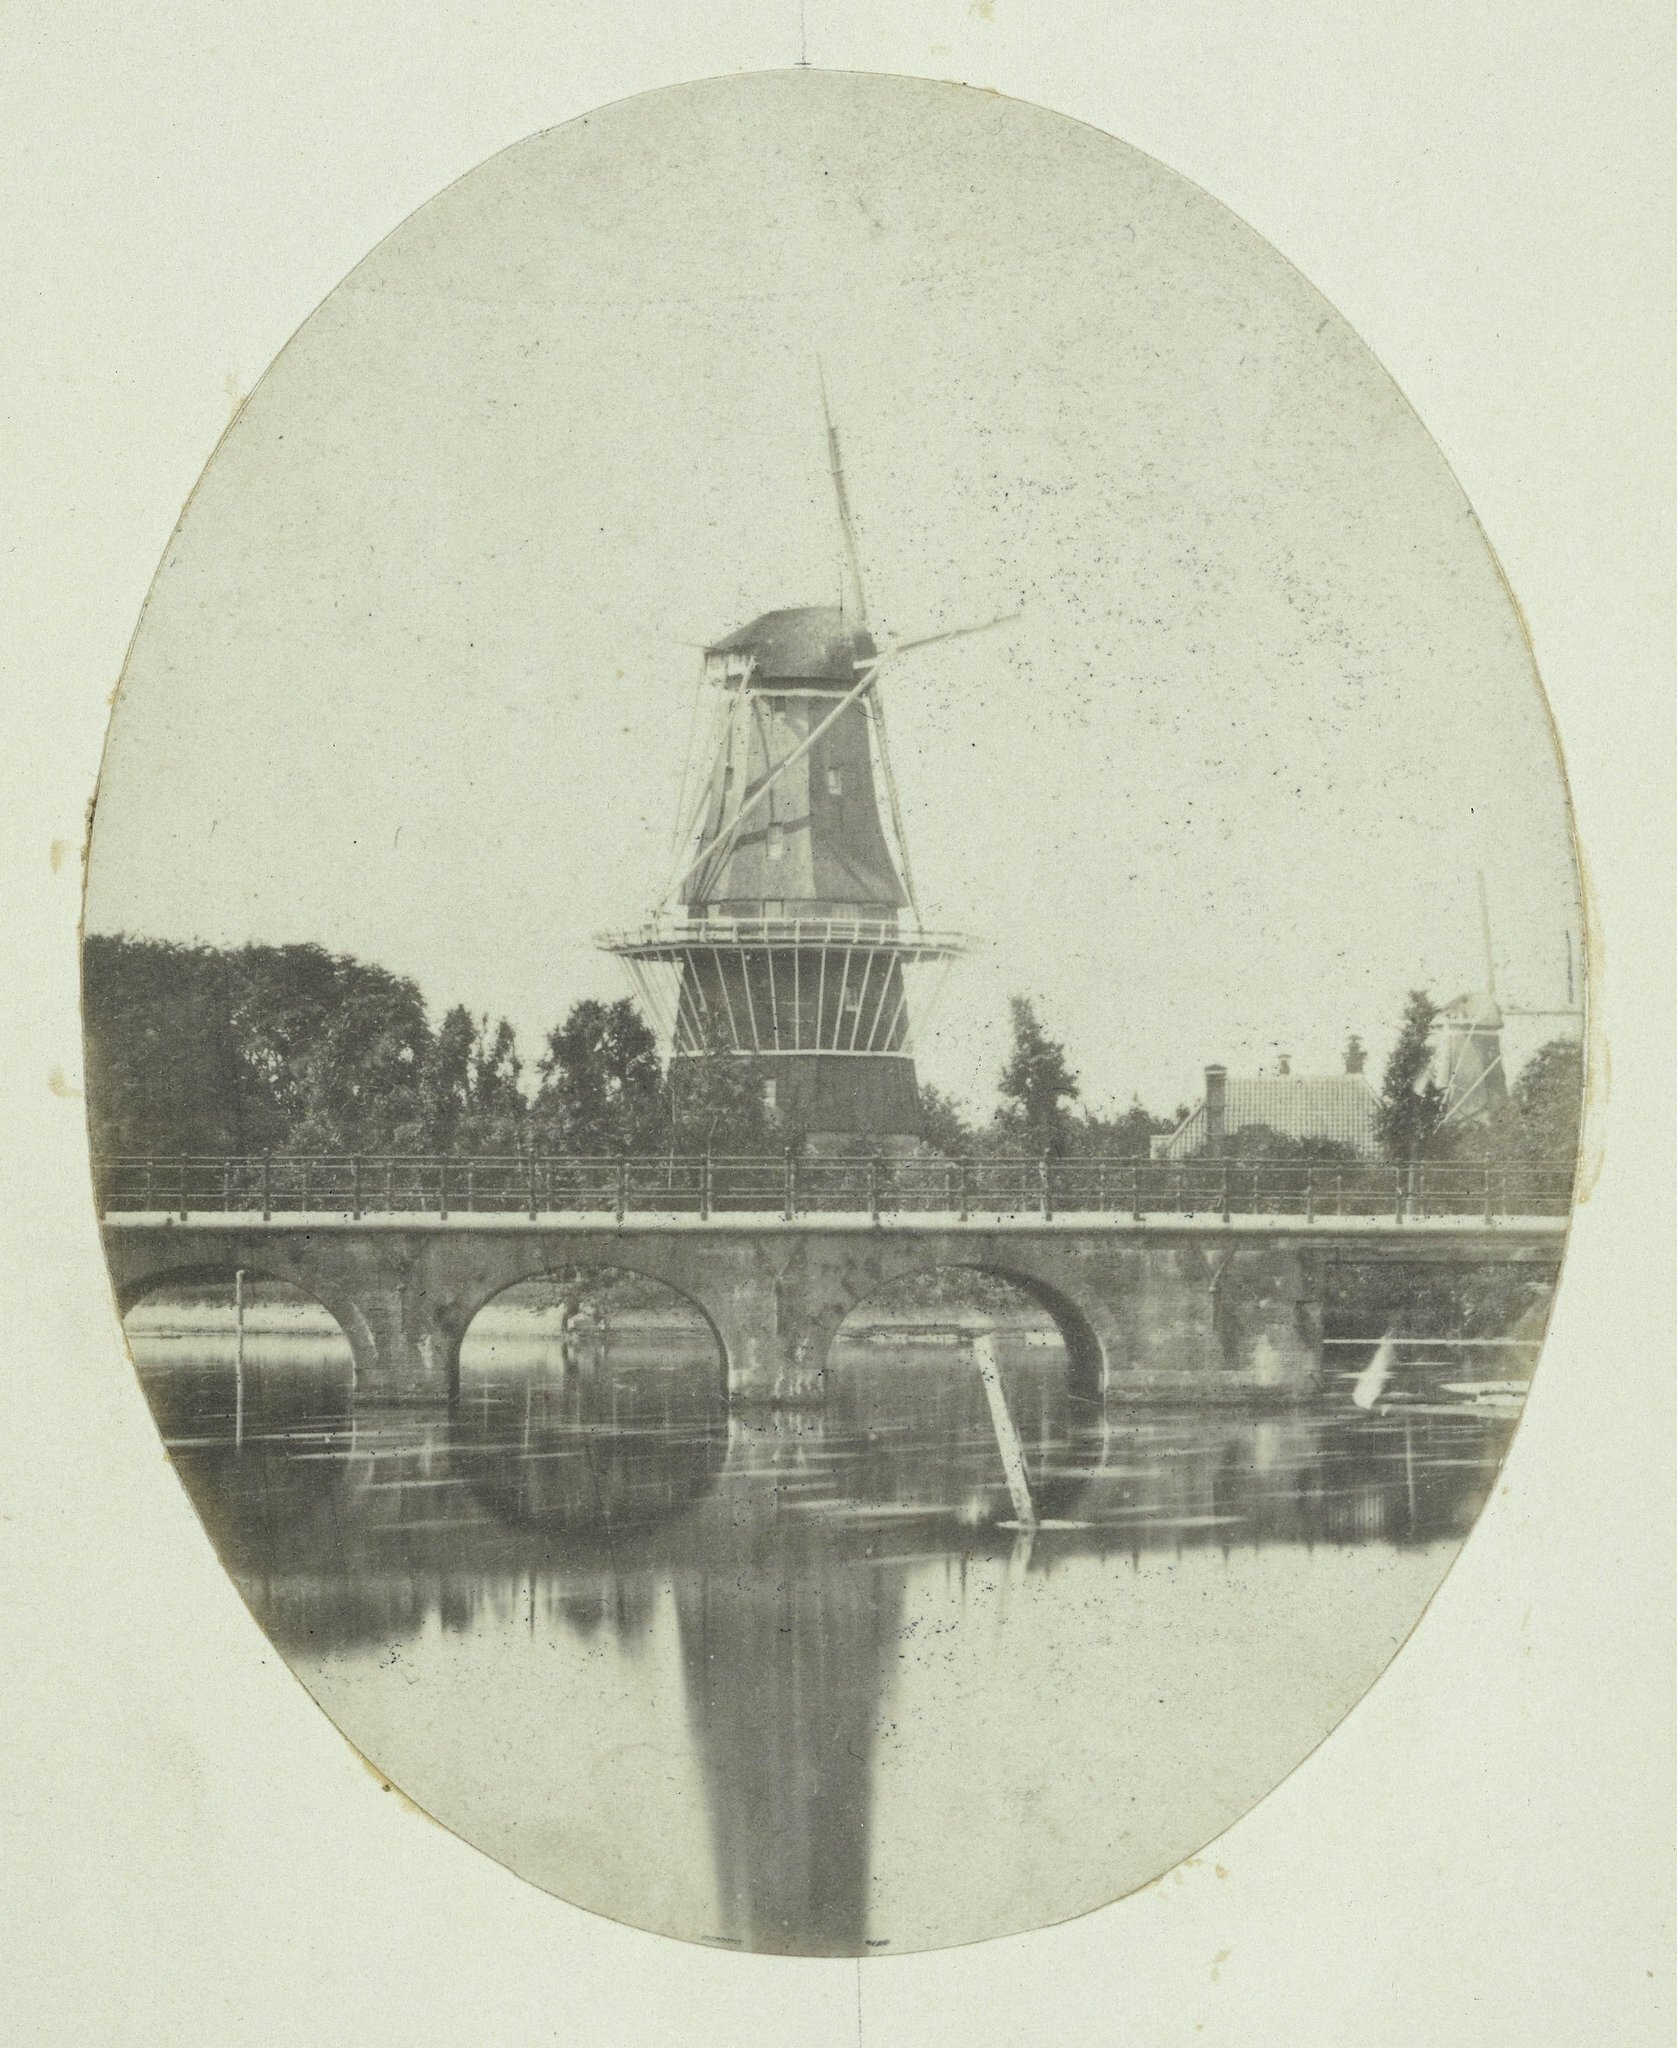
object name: photograph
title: Gezicht op korenmolen 'De Hond' op het bolwerk Muiden bij Amsterdam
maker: eduard isaac asser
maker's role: amateurfotograaf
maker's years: 1809-1894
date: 1852-1860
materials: cardboard, paper, photographic support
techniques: salted paper print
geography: amsterdam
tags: muiden